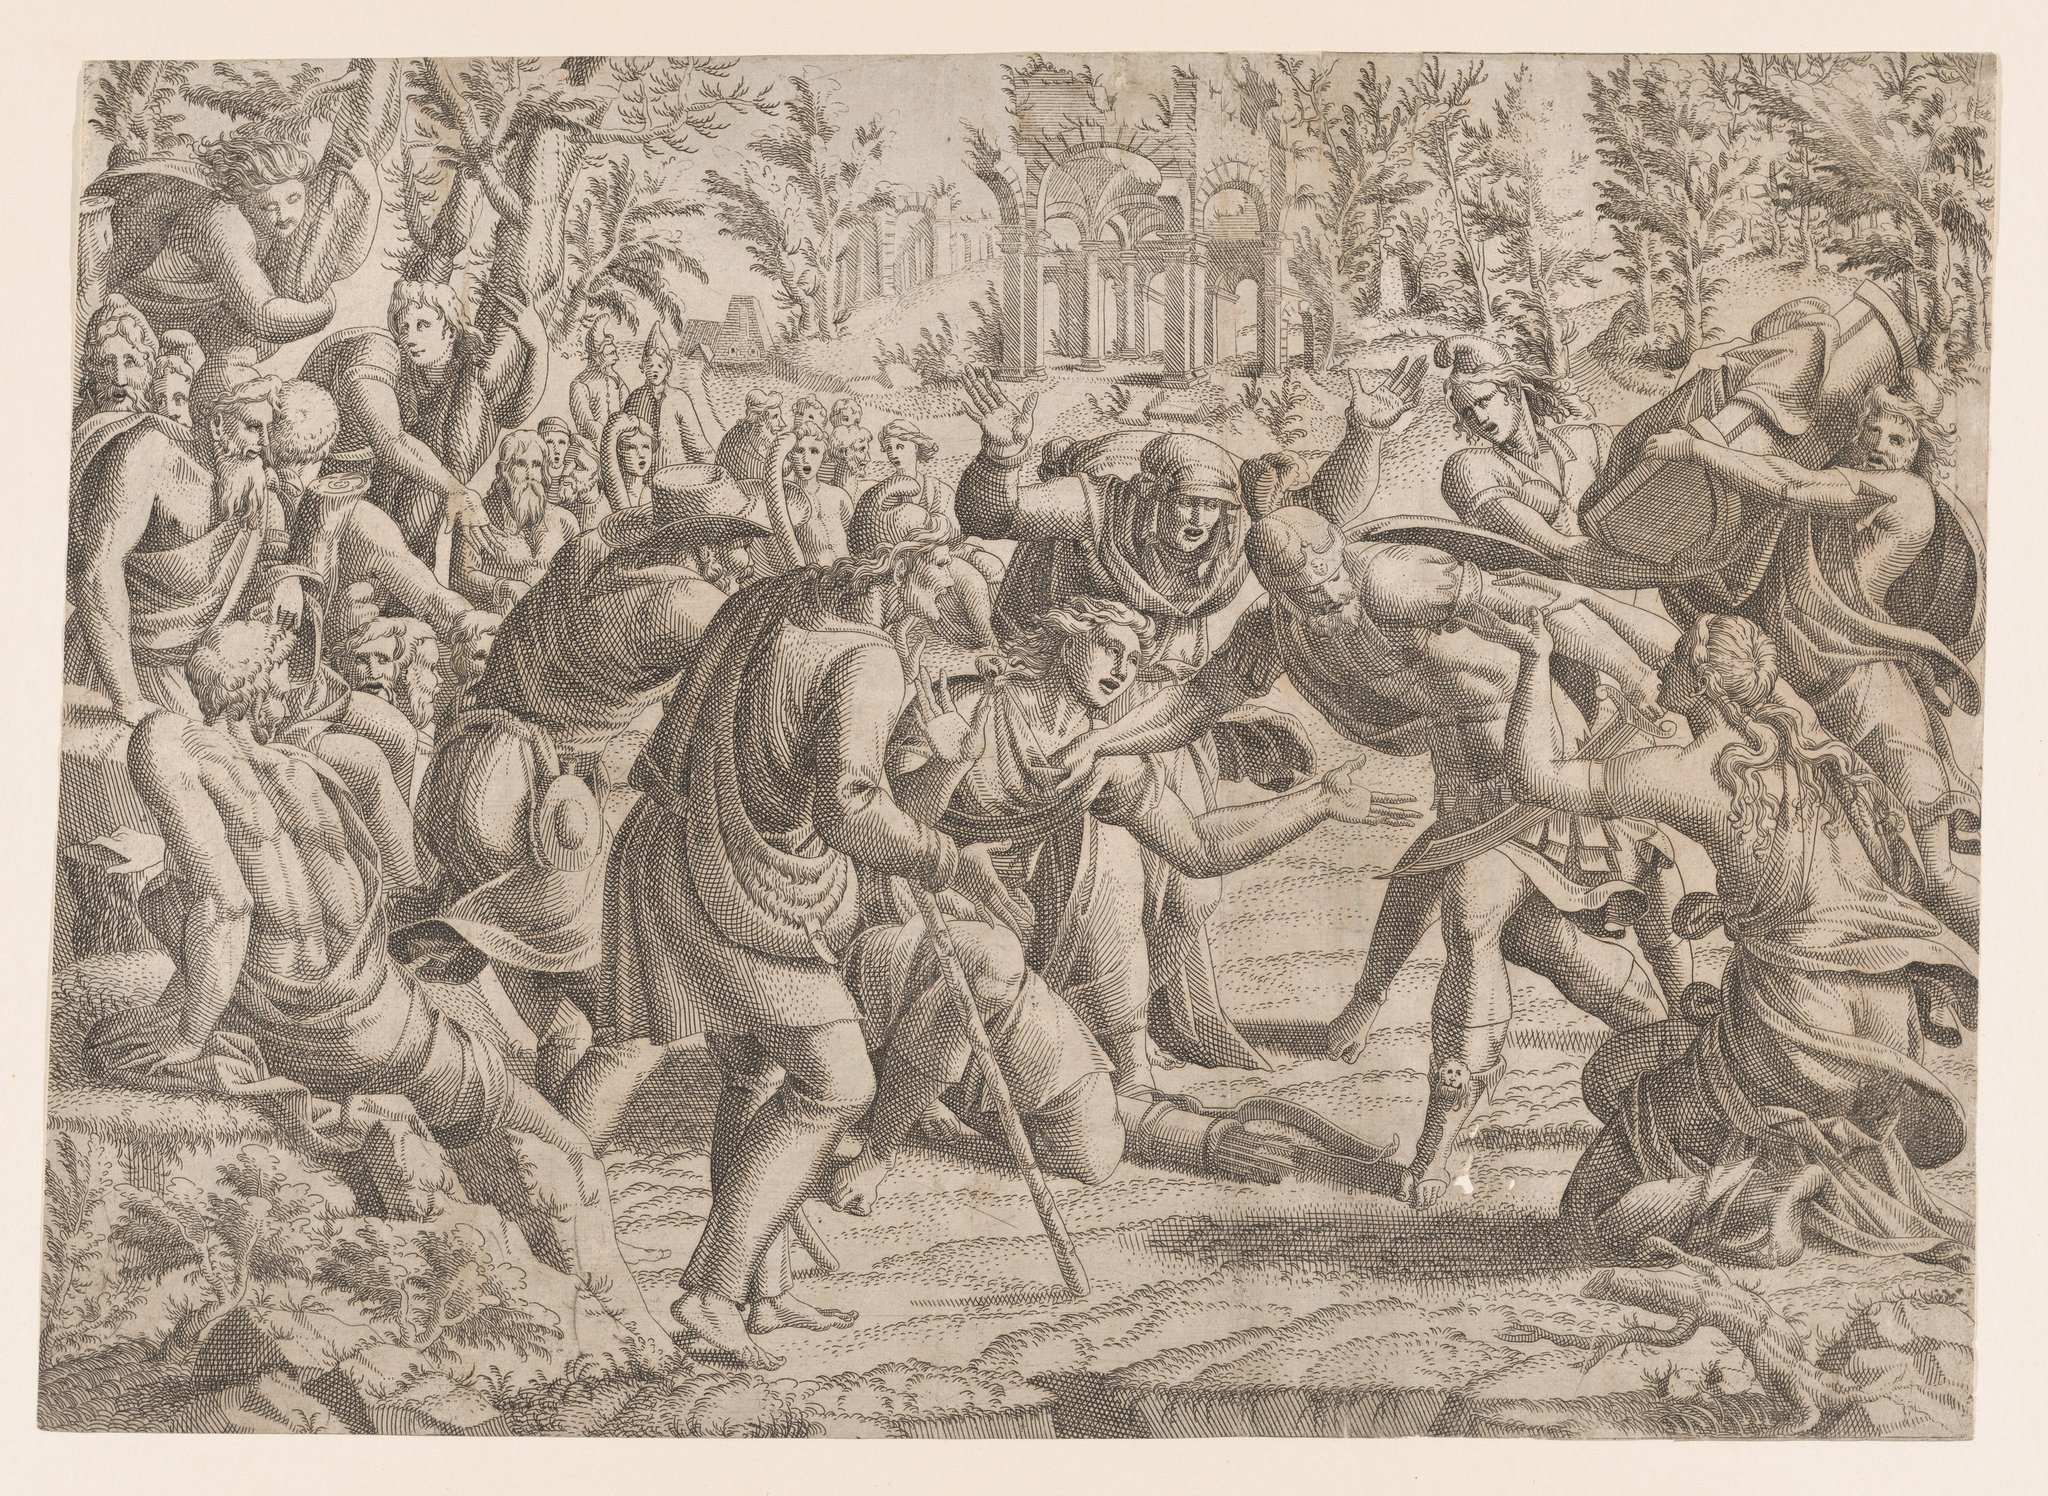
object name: print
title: Cassandra Stopping Deiphobus from Killing Paris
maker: jean mignon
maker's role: artist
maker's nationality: french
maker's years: 1535-1555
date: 1535-1555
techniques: etching